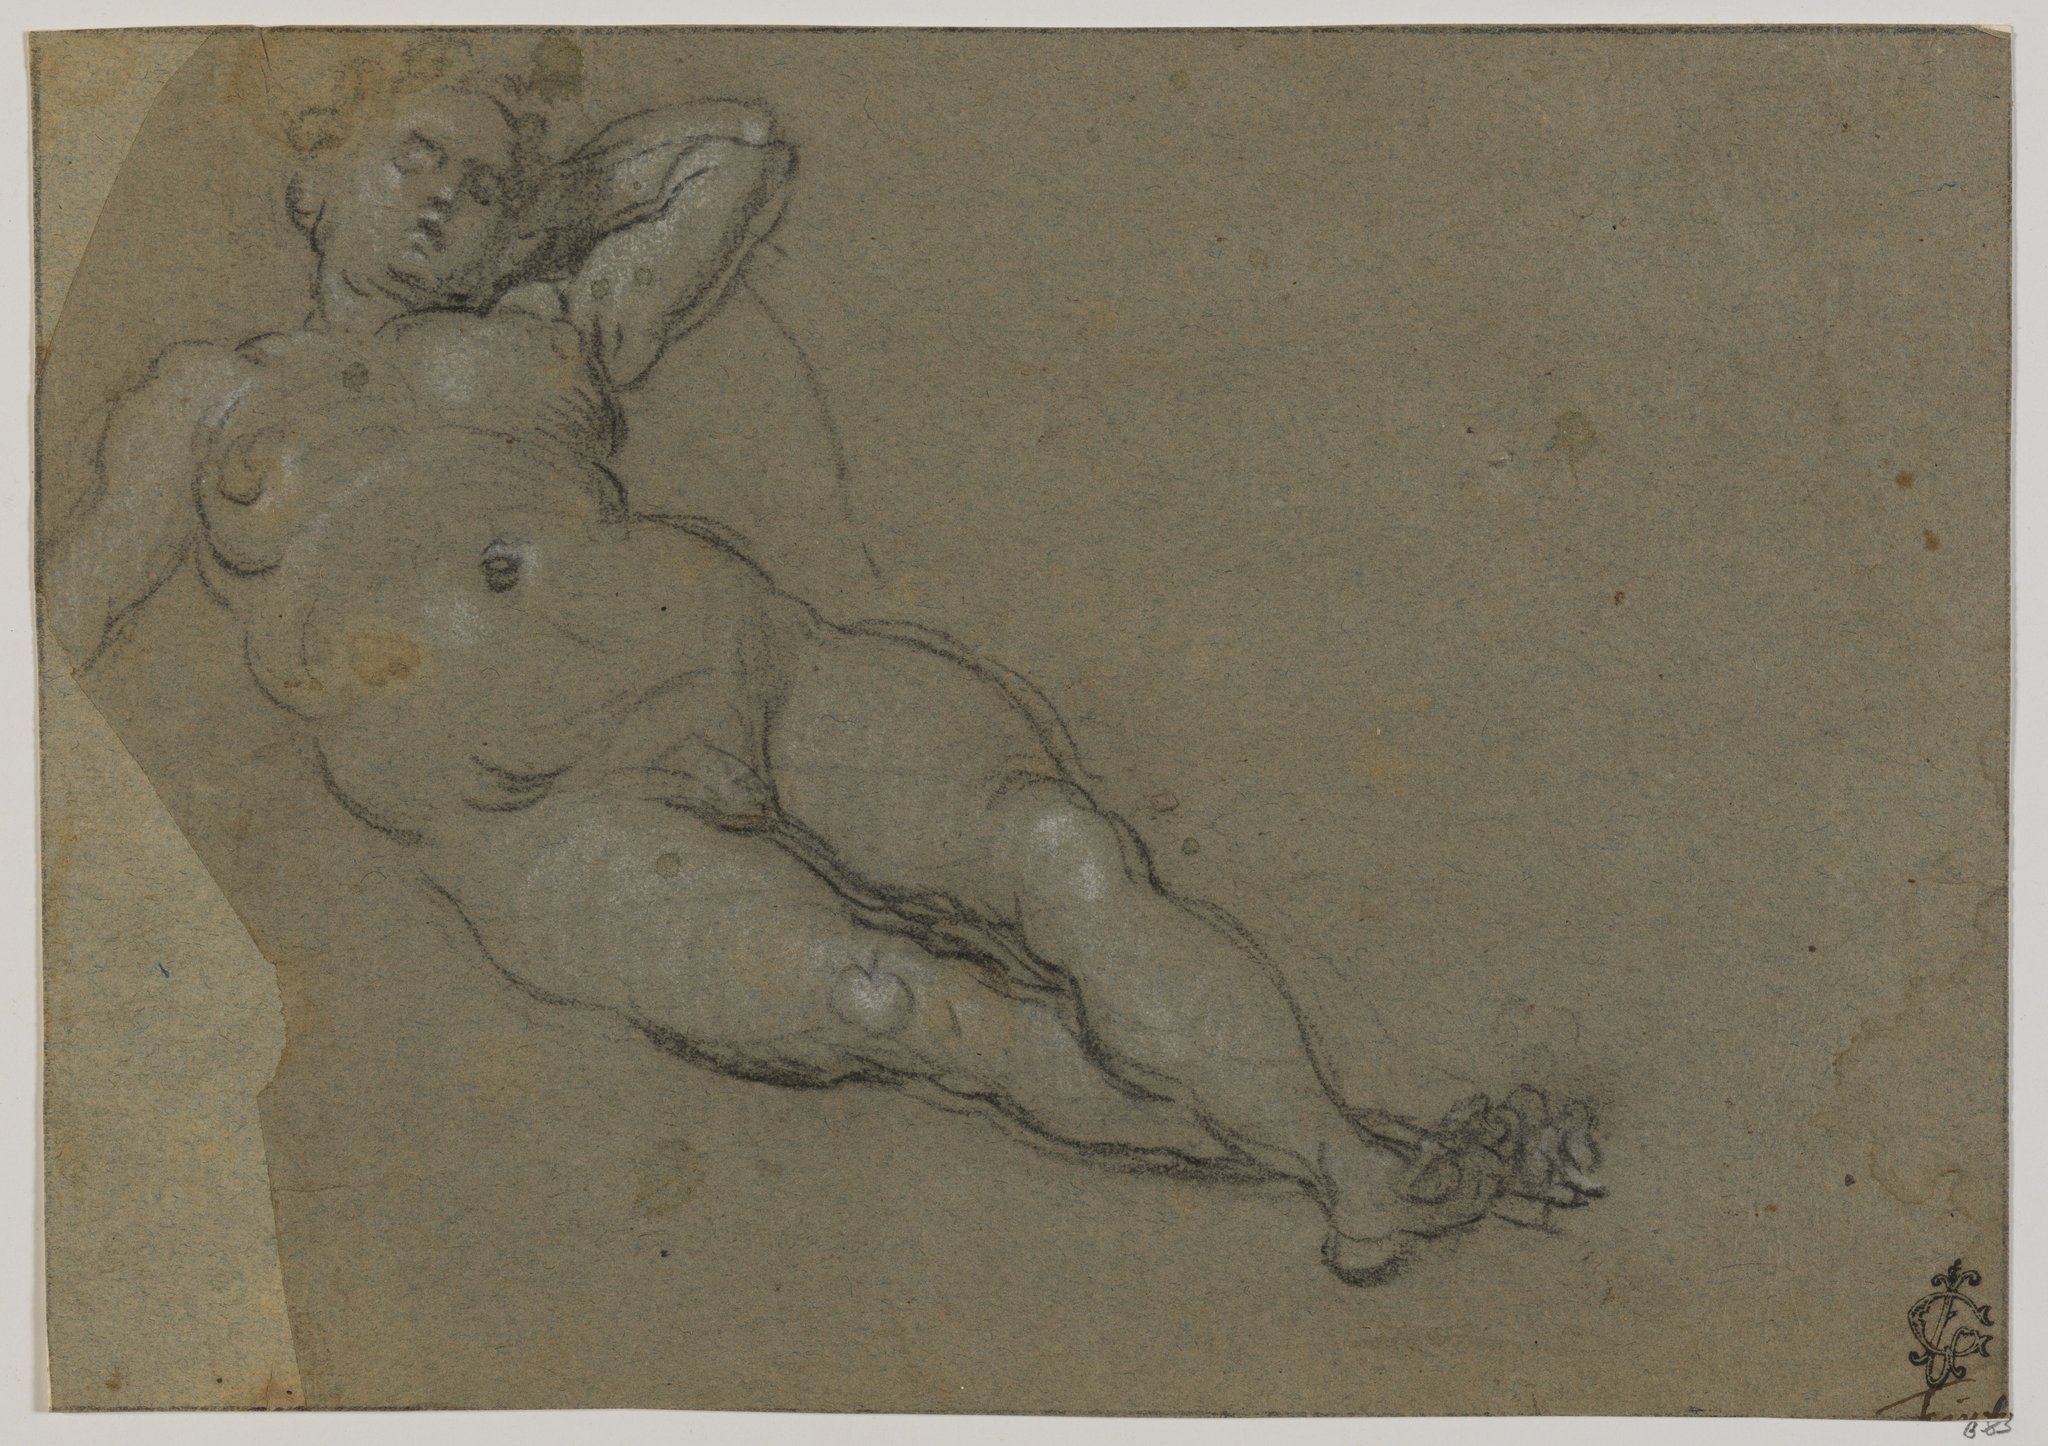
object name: drawing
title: Reclining Female Nude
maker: domenico tintoretto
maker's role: artist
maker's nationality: italian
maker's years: 1560-1635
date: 1601-1633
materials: chalk, paper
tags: female nudes